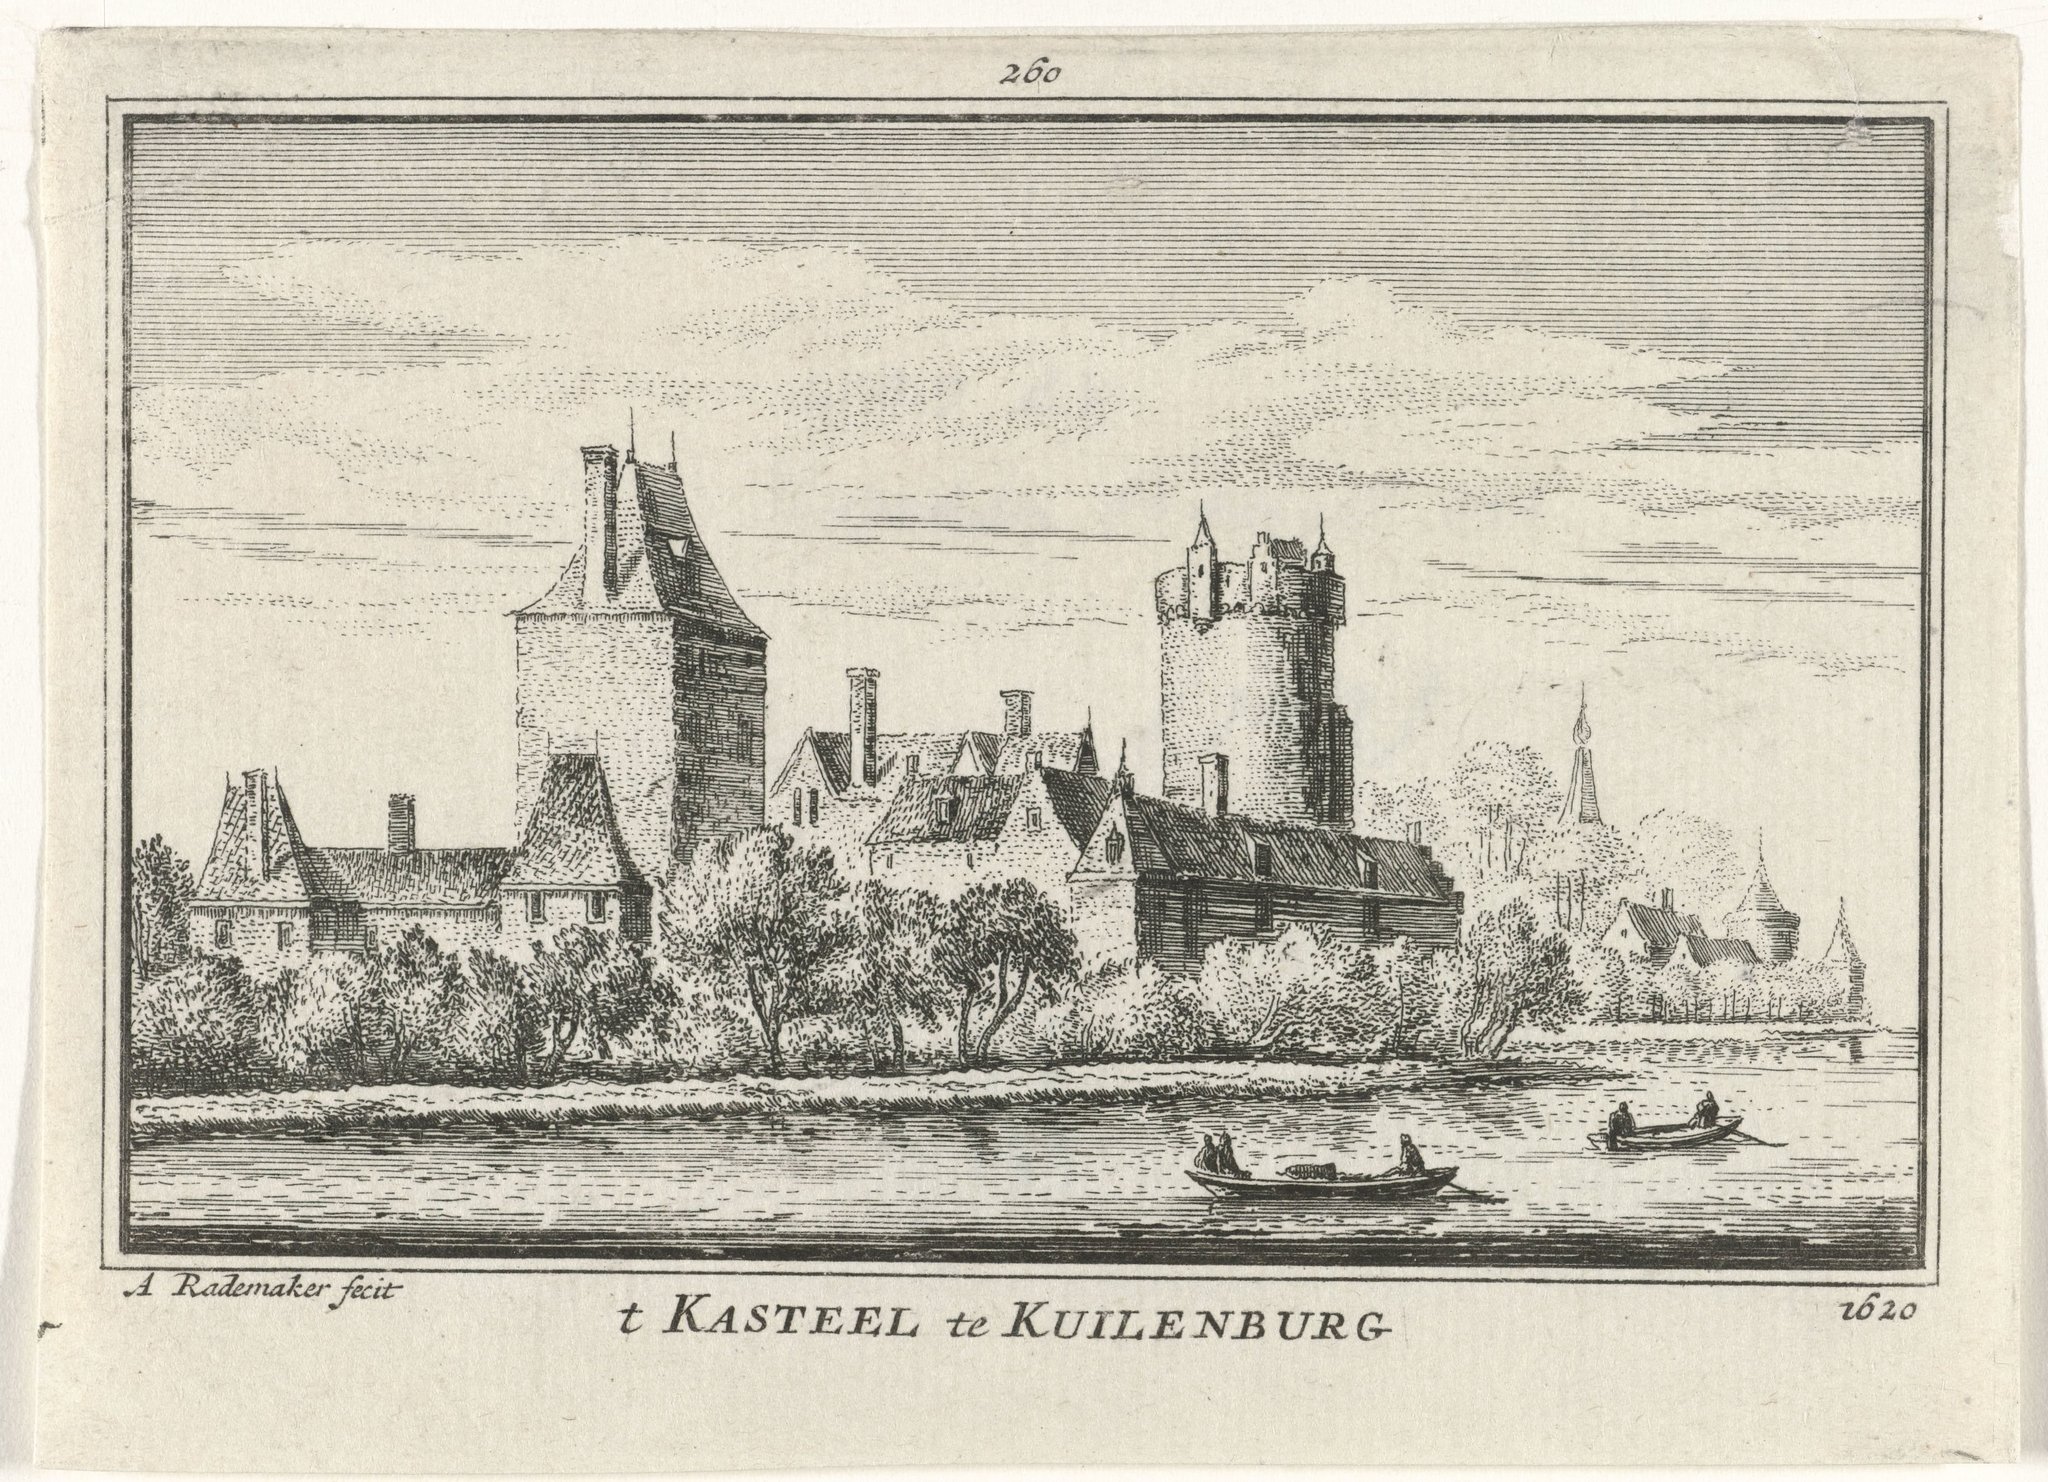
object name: print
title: Kasteel Culemborg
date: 1727-1733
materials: paper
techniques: etching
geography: amsterdam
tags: castle, rowing-boat, canoe, etc.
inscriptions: collector's mark: Lugt 2228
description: Illustratie uit: Abraham Rademaker, Matthaeus Brouërius van Niedek, Isaac Le Long, Kabinet van Nederlandsche en Kleefsche outheden en (...) voorname stads- en landgebouwen, Willem Barents en Antoni Schoonenburg: Amsterdam, 1727-1733, ill. nr. 260.